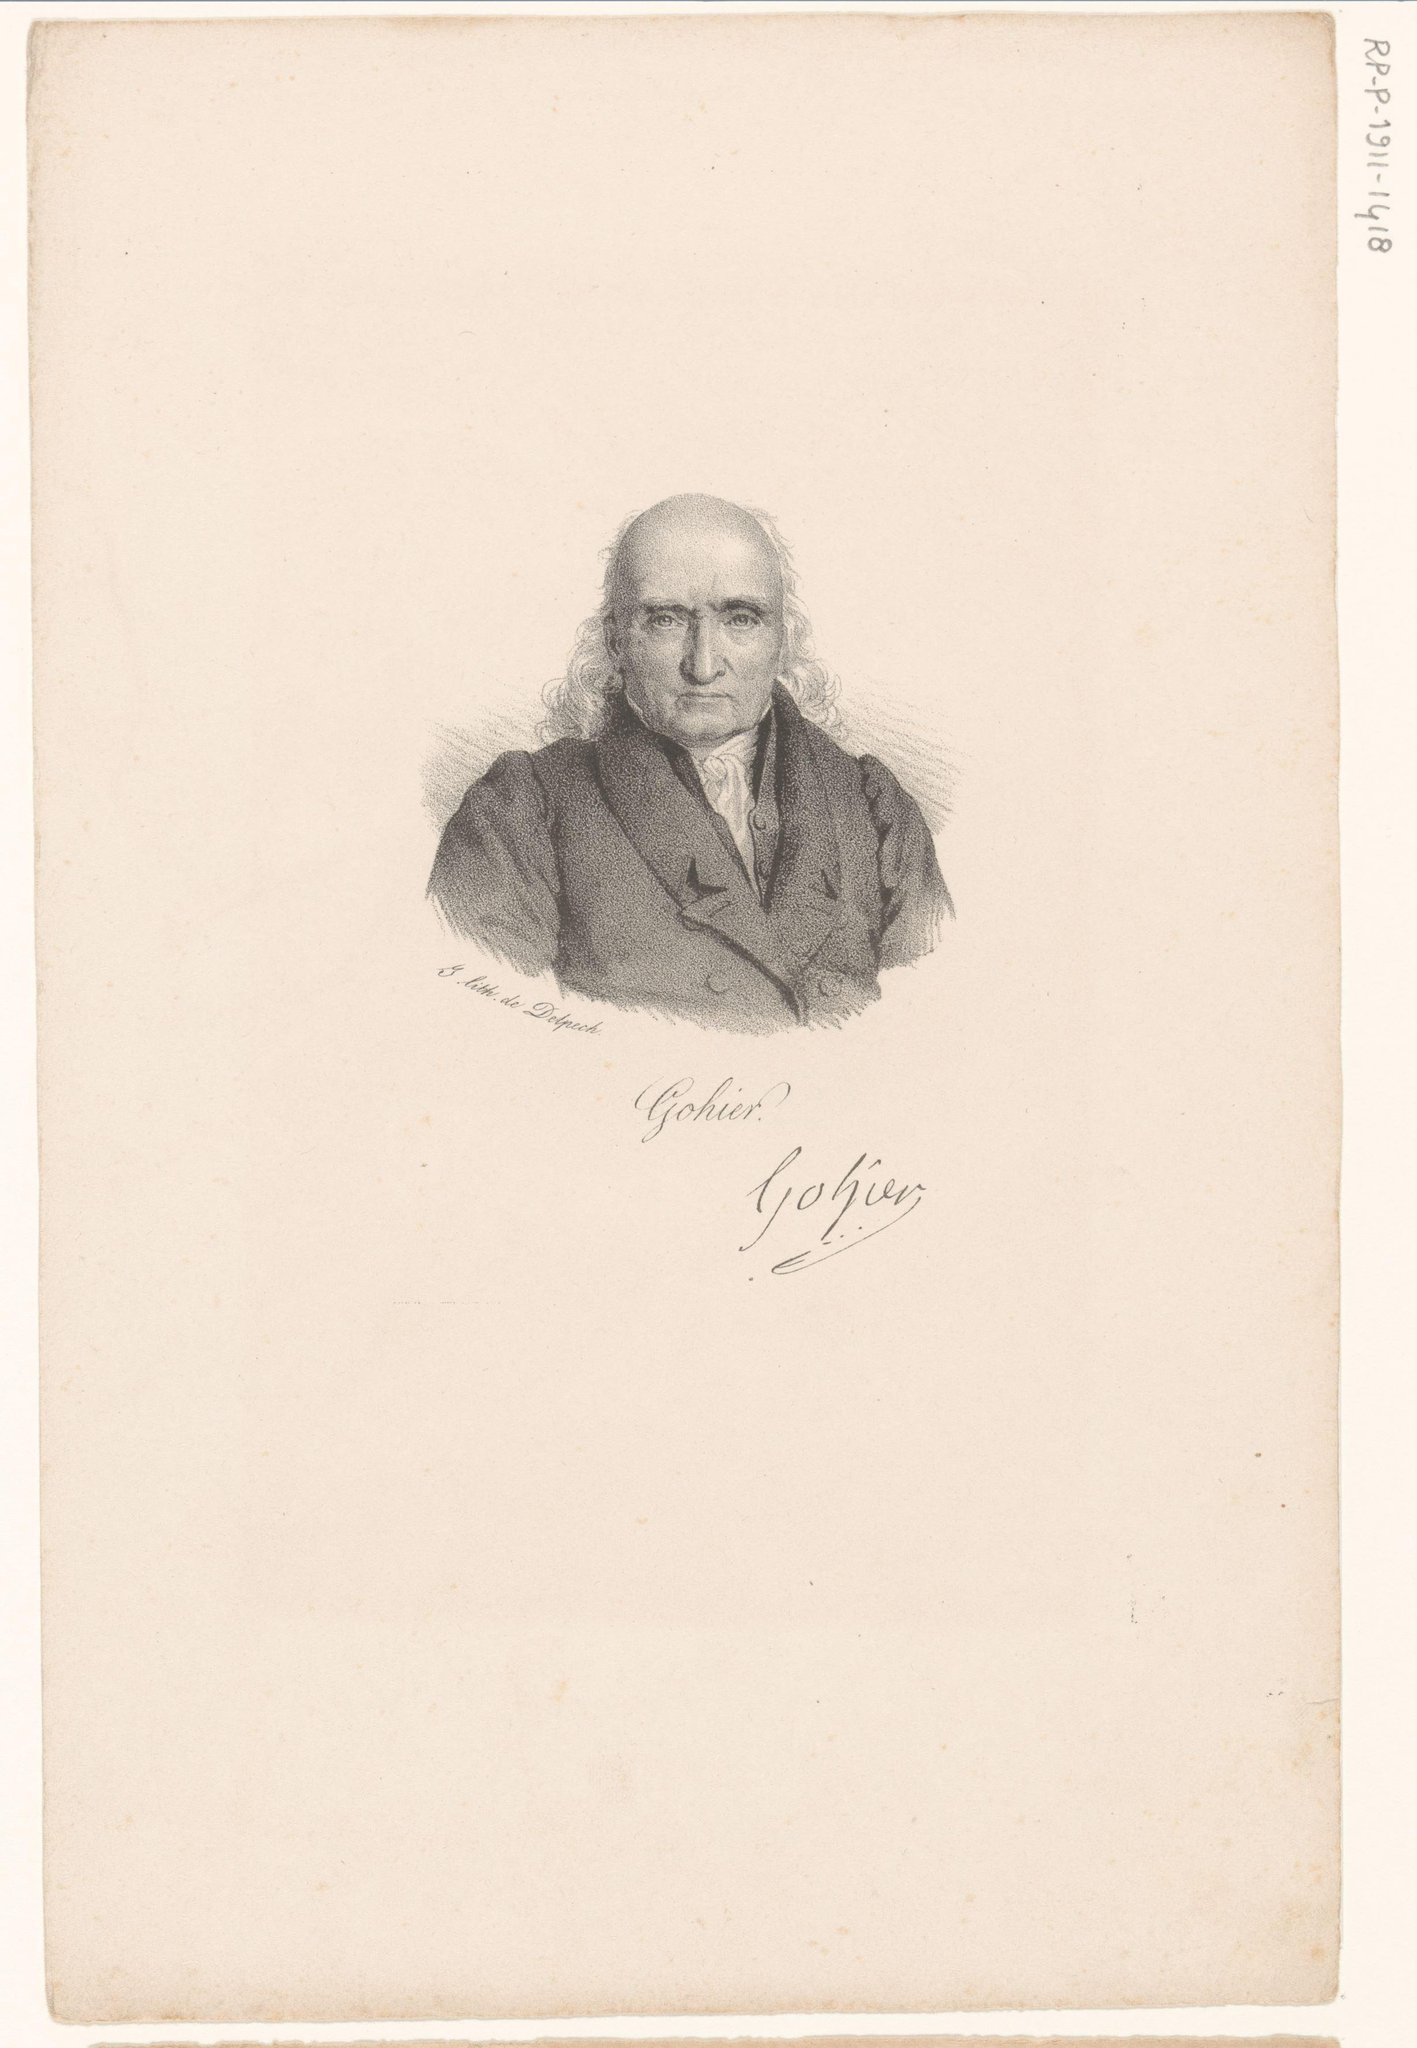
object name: print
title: Gohier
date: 1818-1842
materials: paper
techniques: lithograph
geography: paris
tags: politician, historical persons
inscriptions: collector's mark: Lugt 2228a